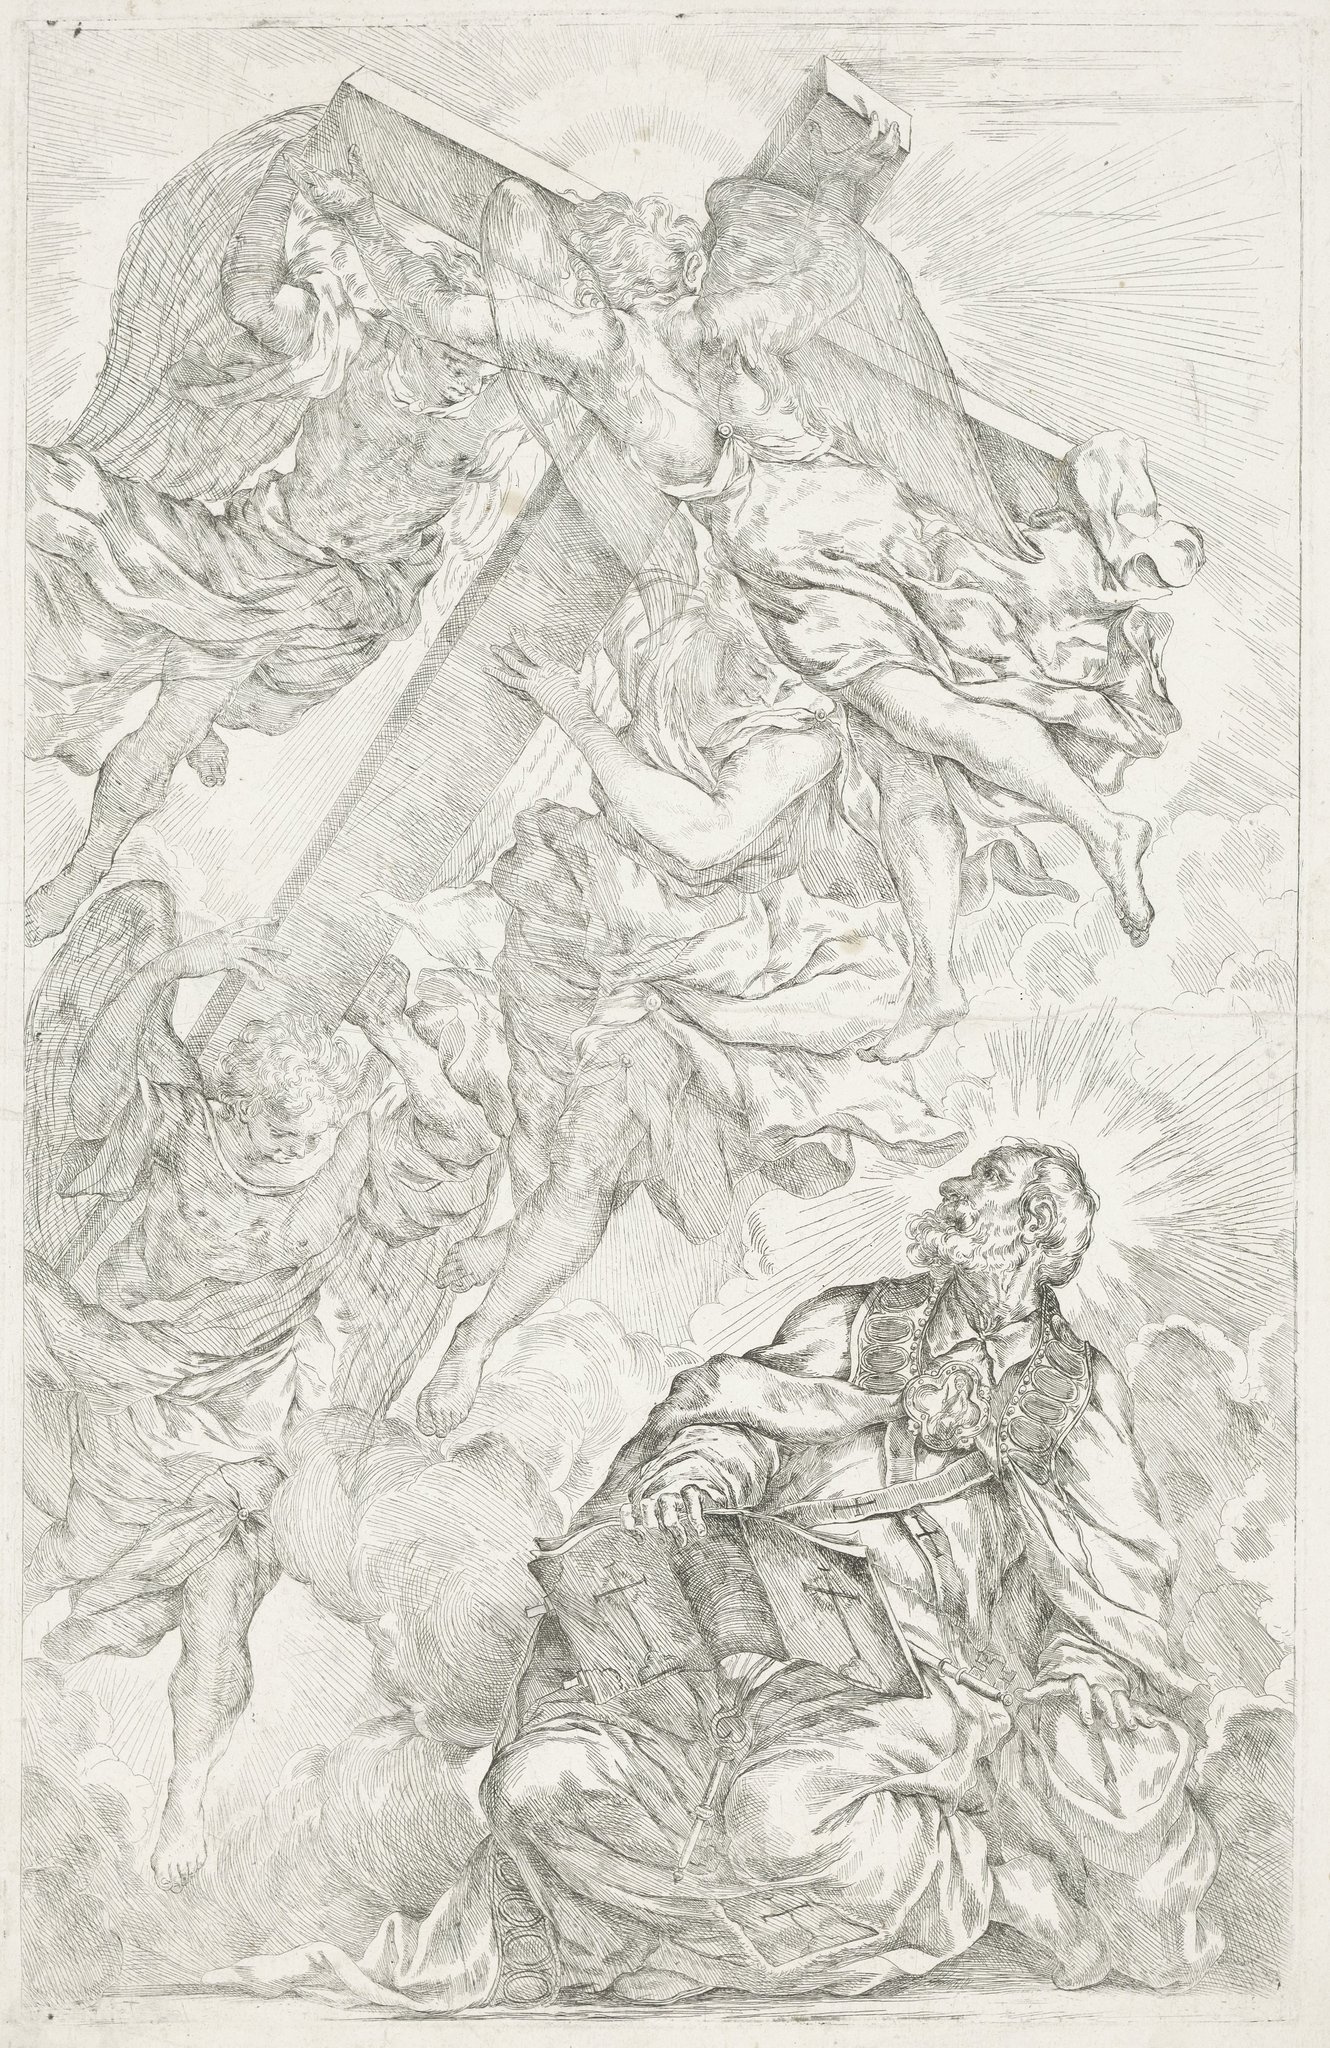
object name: print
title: De verschijning van het kruis aan Petrus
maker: Anonymous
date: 1528-1594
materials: paper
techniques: etching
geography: venice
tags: the apostle peter, first bishop of rome; possible attributes: book, cock, (upturned) cross, (triple) crozier, fish, key, scroll, ship, tiara - miraculous activities and events ~ male saint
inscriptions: collector's mark: Lugt 2760, collector's mark: Lugt 2228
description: Naar een schilderij door Tintoretto in de Chiesa Madonna dell' Orto te Venetië, voorheen onderdeel van een orgel in deze kerk.